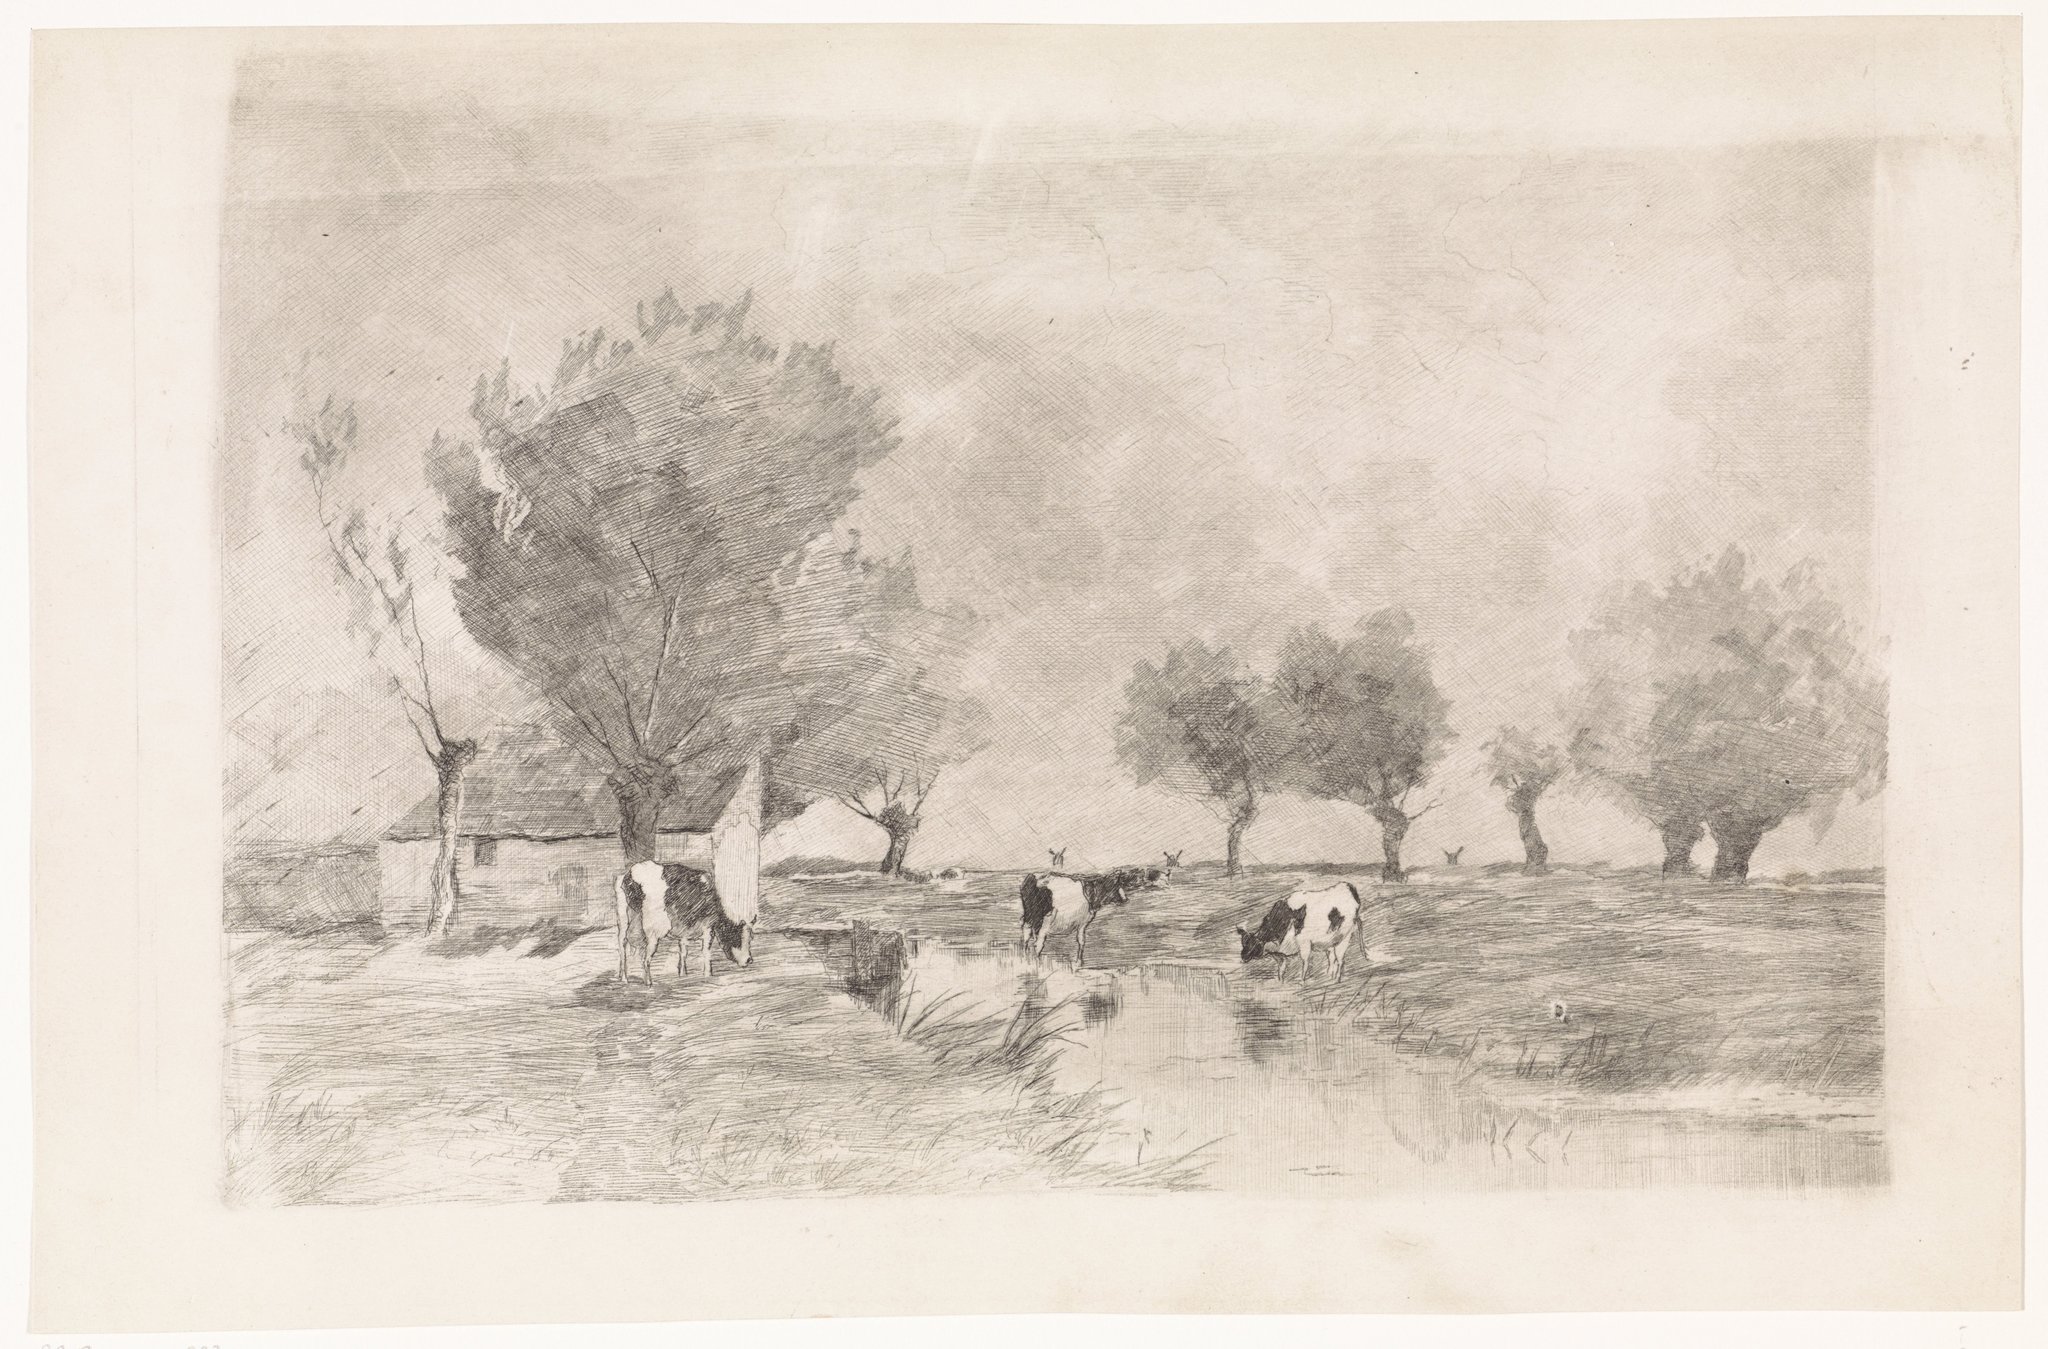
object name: print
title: Landschap met drie koeien bij een sloot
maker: elias stark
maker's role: draughtsman, print maker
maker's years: 1849-1933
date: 1859-1890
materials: paper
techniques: drypoint, etching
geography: netherlands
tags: cow, swamps and polders, trees: willow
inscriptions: collector's mark: Lugt 2228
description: Landschap met drie koeien bij een sloot. Links een huis en aan de horizon drie molens.